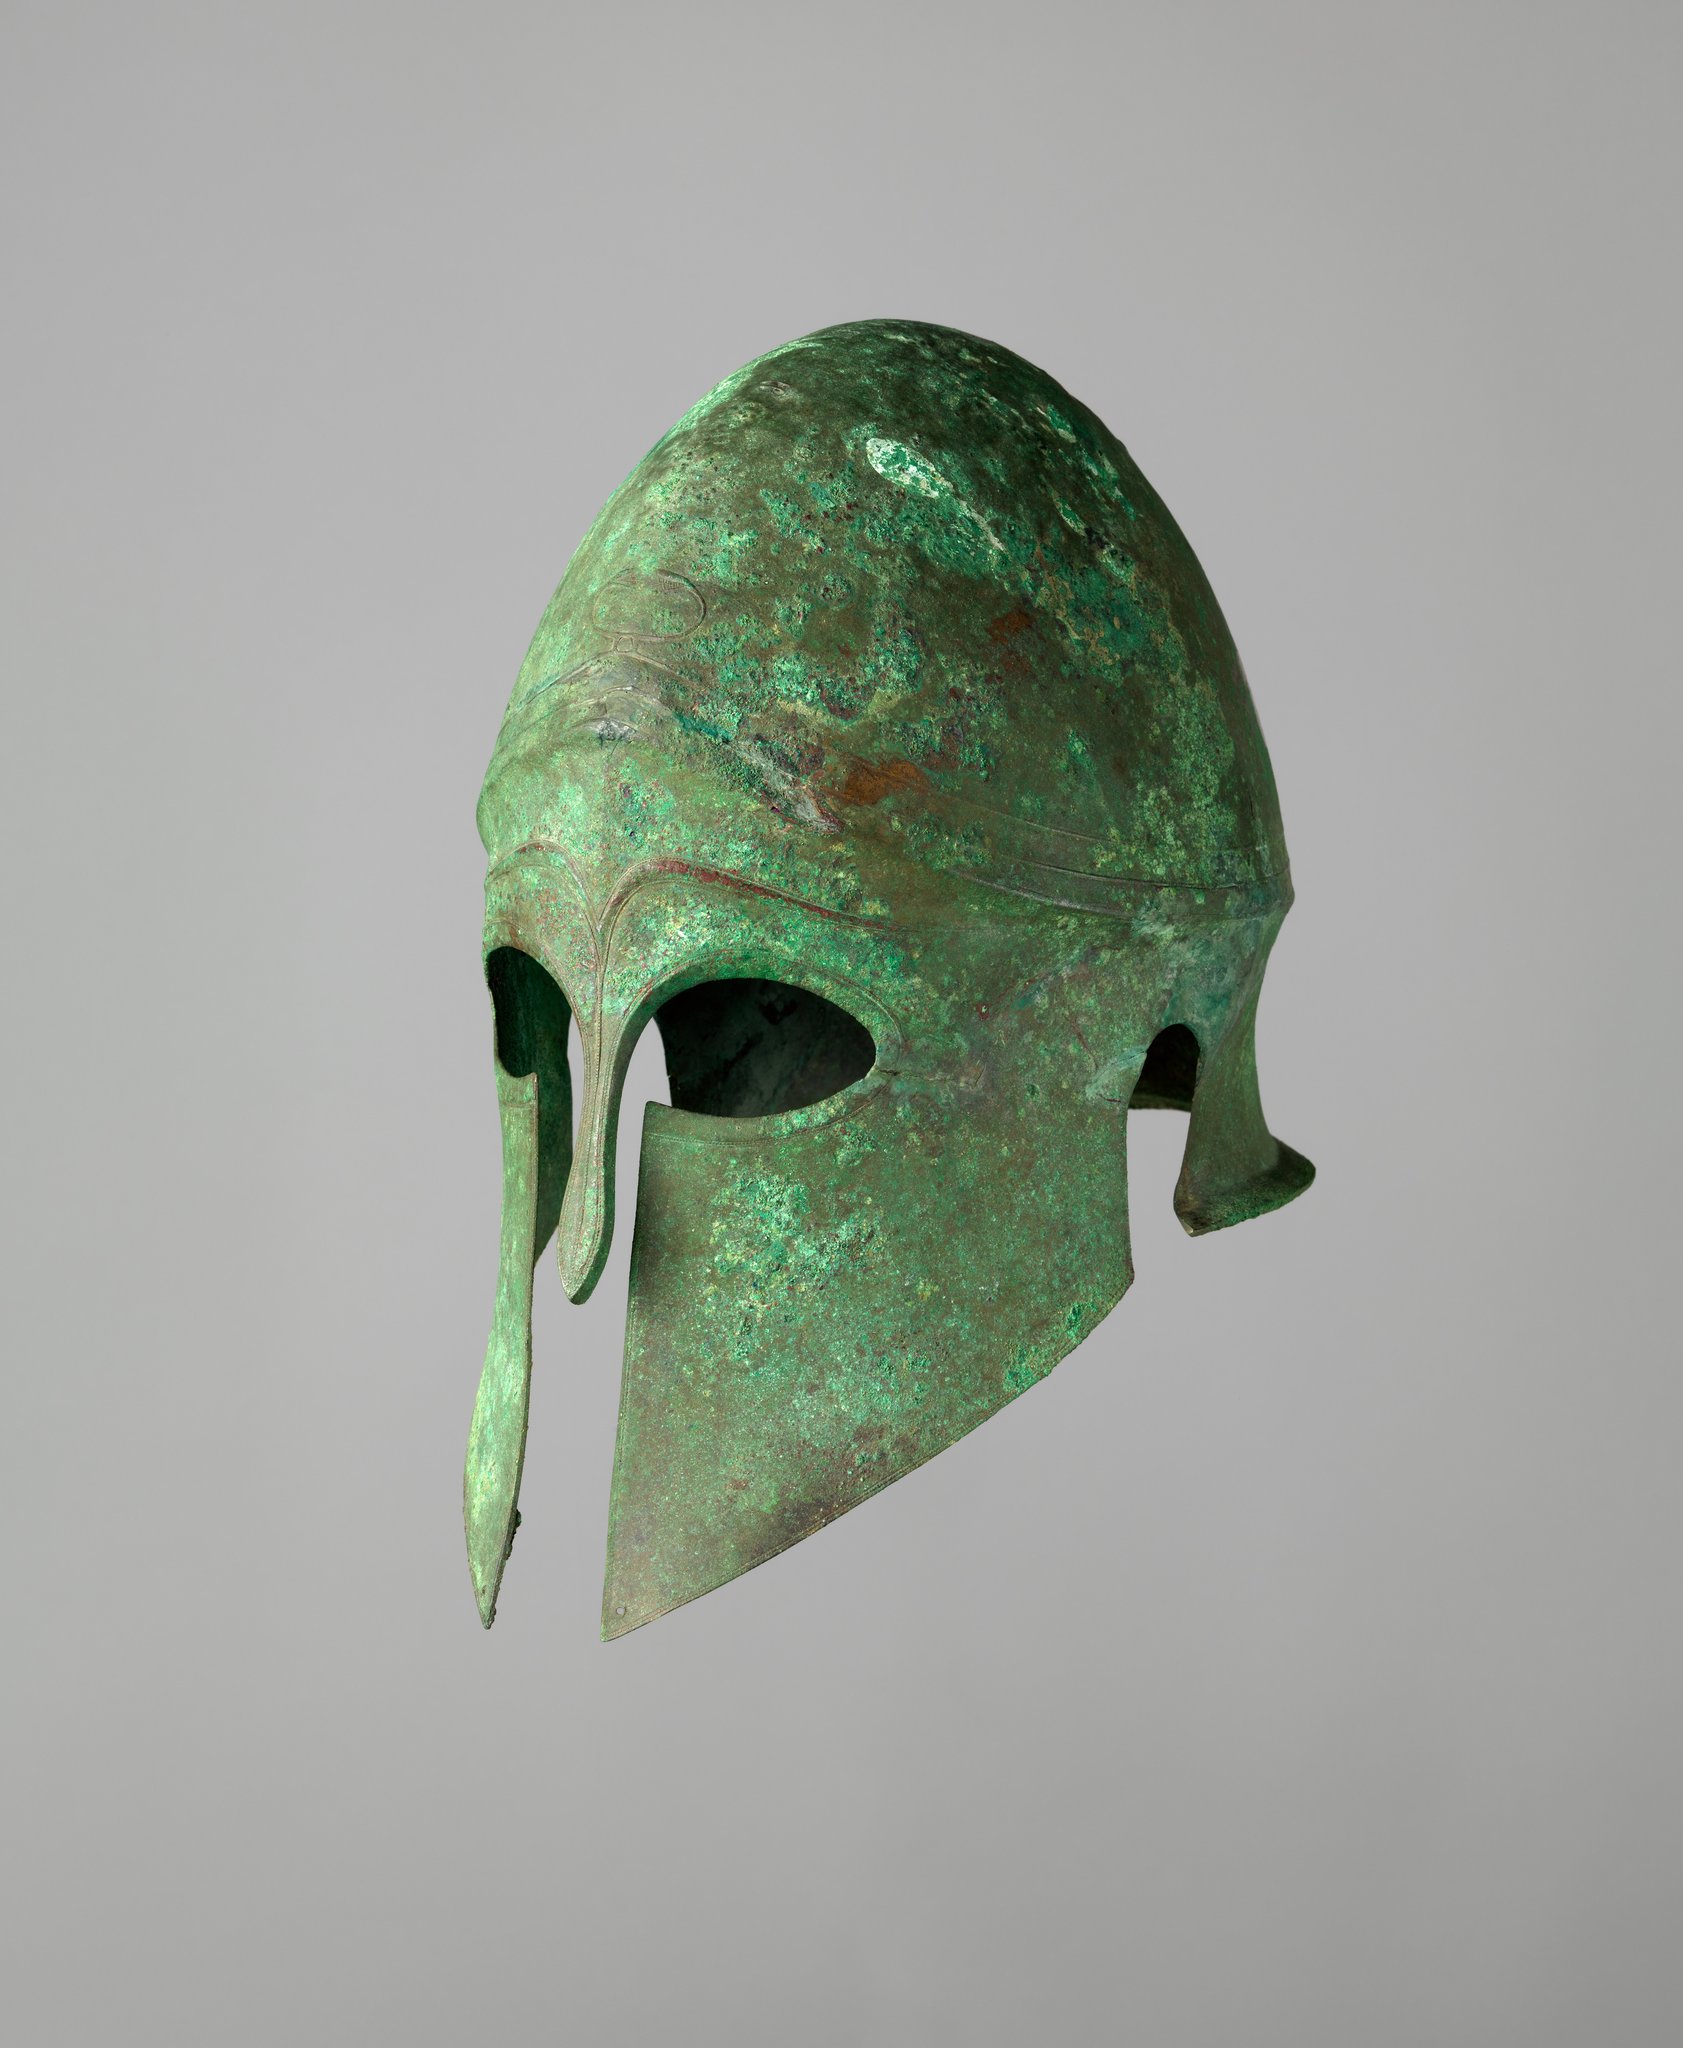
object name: helmet and greave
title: Helmet of the Corinthian Type and Pair of Greaves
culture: greek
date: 500-468 BCE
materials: bronze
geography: italy